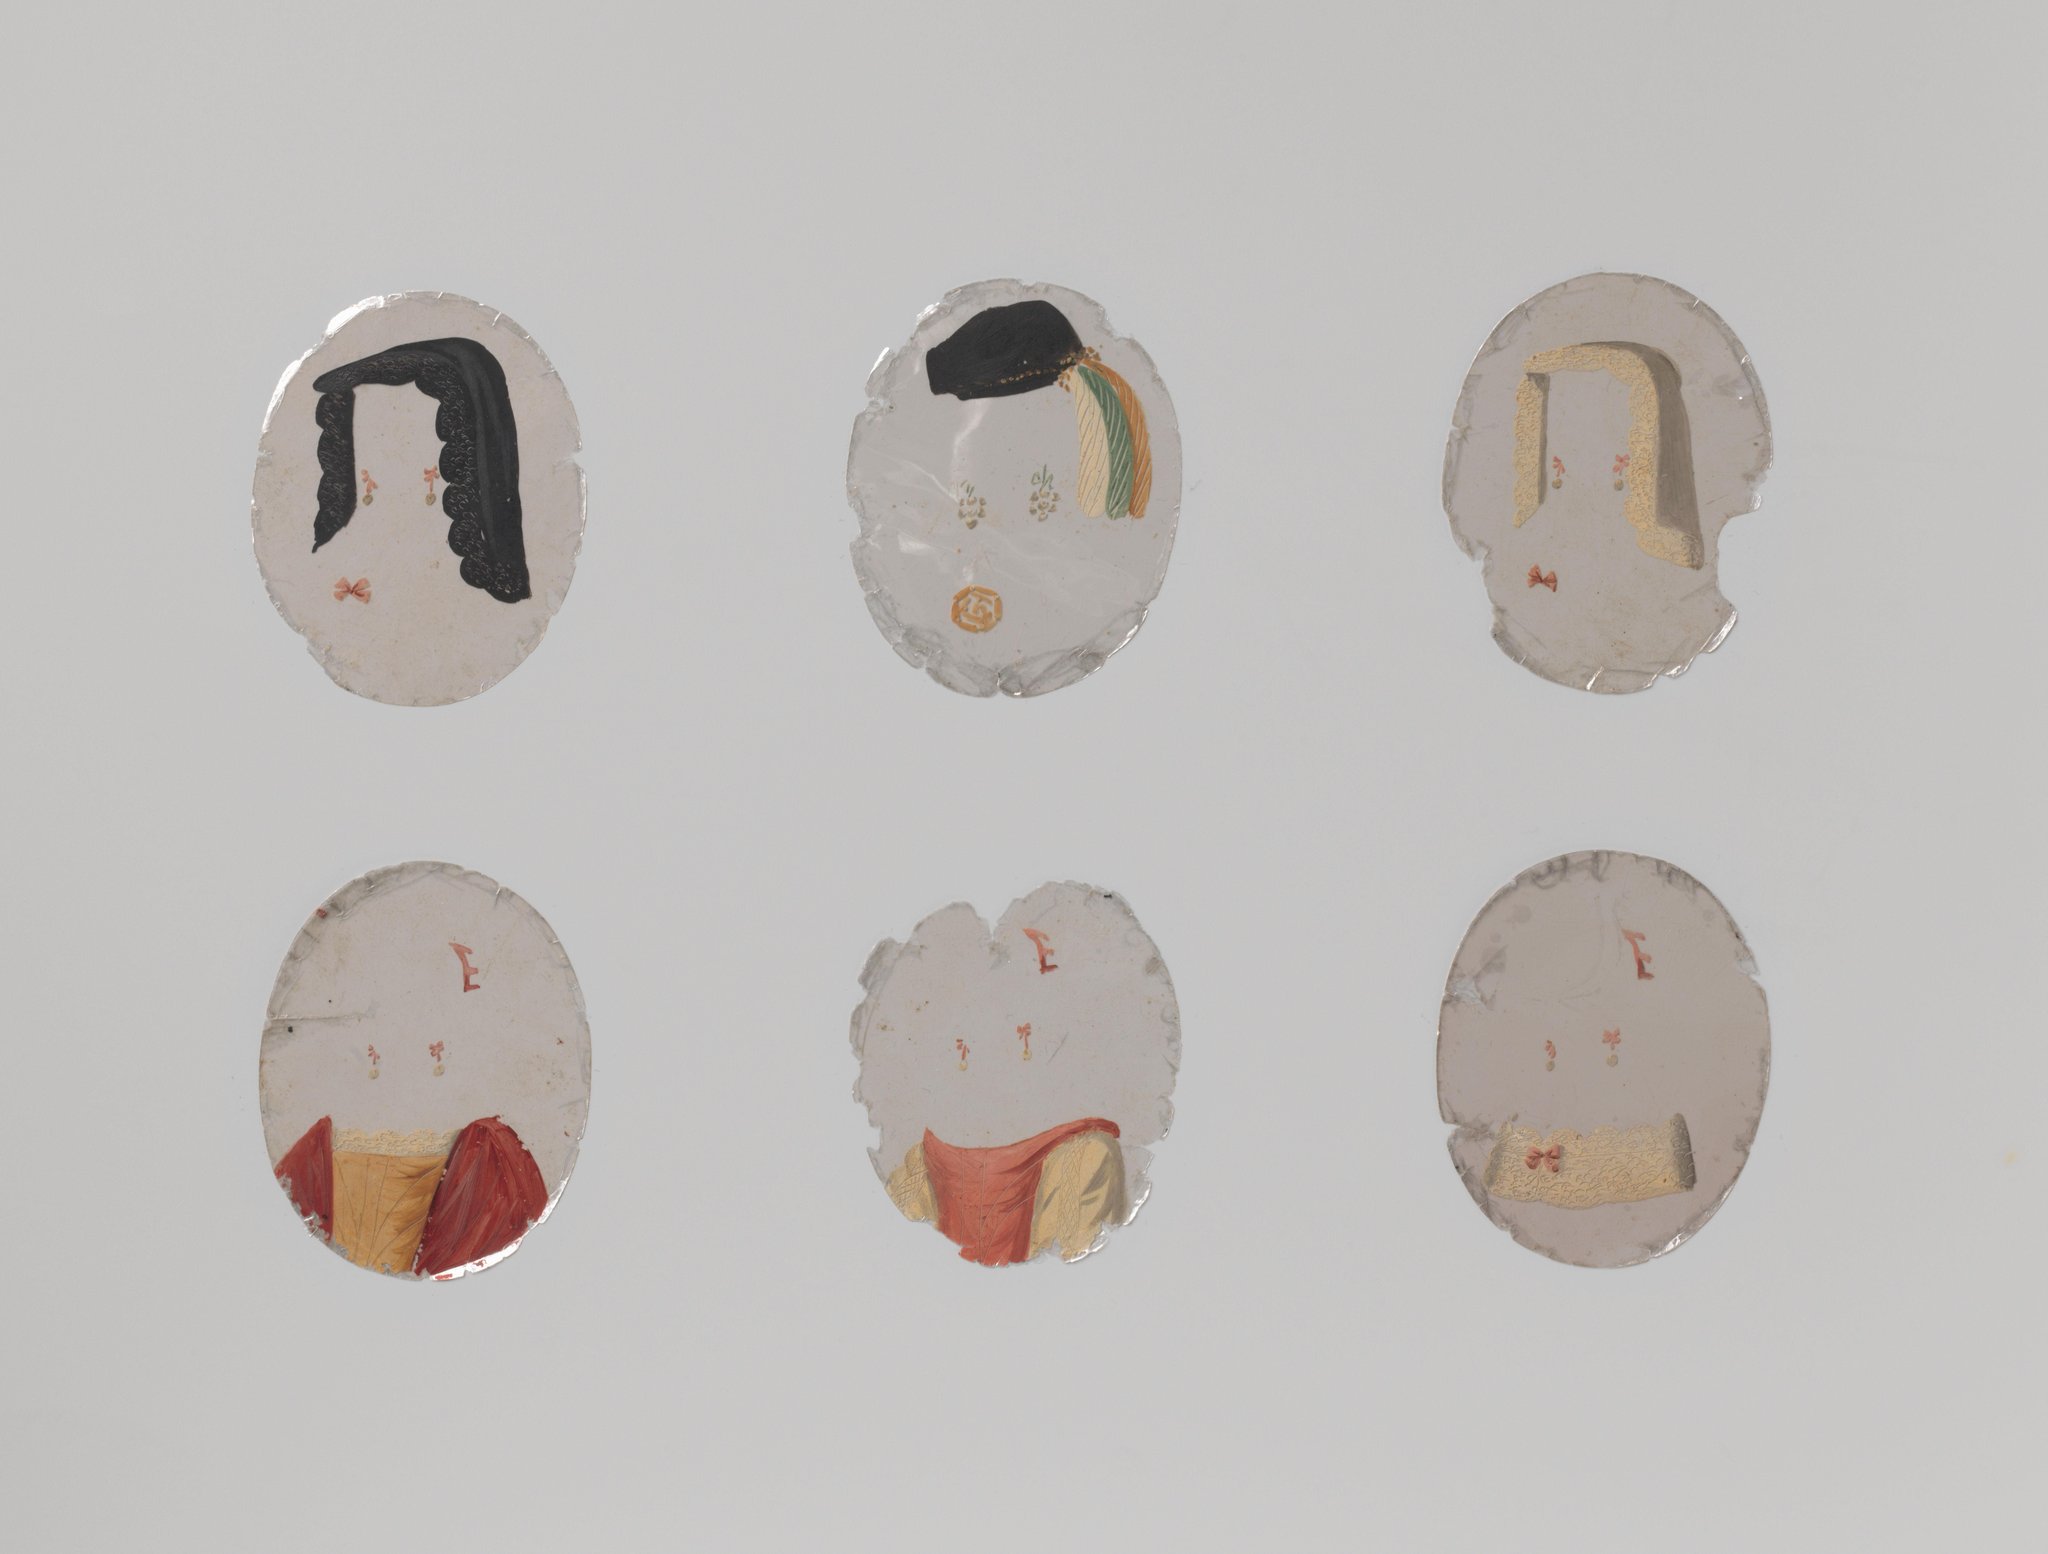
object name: souvenir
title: 32 transparantjes van mica waarop met tempera verschillende kostuums zijn geschilderd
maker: Anonymous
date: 1640-1660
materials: paint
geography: northern netherlands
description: Transparantjes (overlay), 32 stuks van mica waarop met tempera verschillende kostuums zijn geschilderd. Het portretminiatuur, waarop de transparantjes gelegd moeten worden, ontbreekt. De verkledingen vertonen daagse vrouwenkostuums met oorbellen, broches en diverse gepluimde hoeden, evenals een weduwenkap, mutsen van witte en zwarte kant. Verder mannnenkostuums, een tulband, koninginnekroon, hermelijn en verschillende orde-drachten.